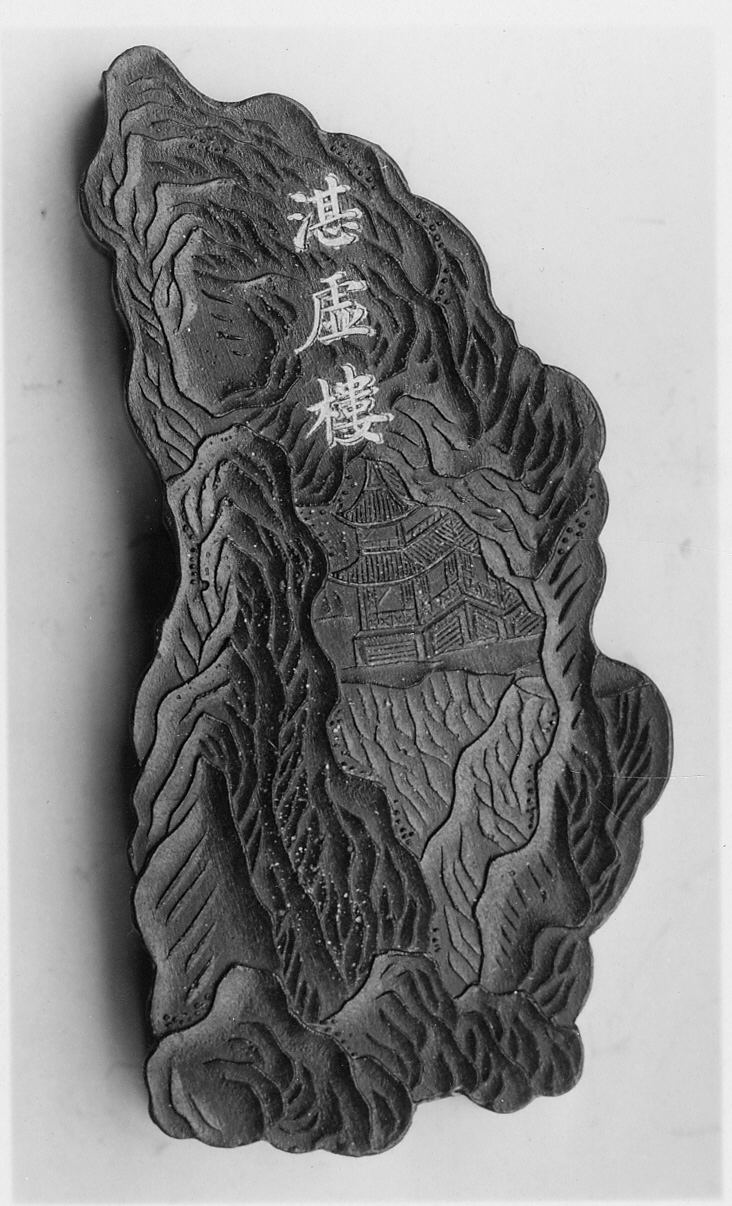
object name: ink tablet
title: Clear Void Tower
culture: chinese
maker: jian guzhai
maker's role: artist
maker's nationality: chinese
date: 1867-1933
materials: gilt, wood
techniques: bookbinding